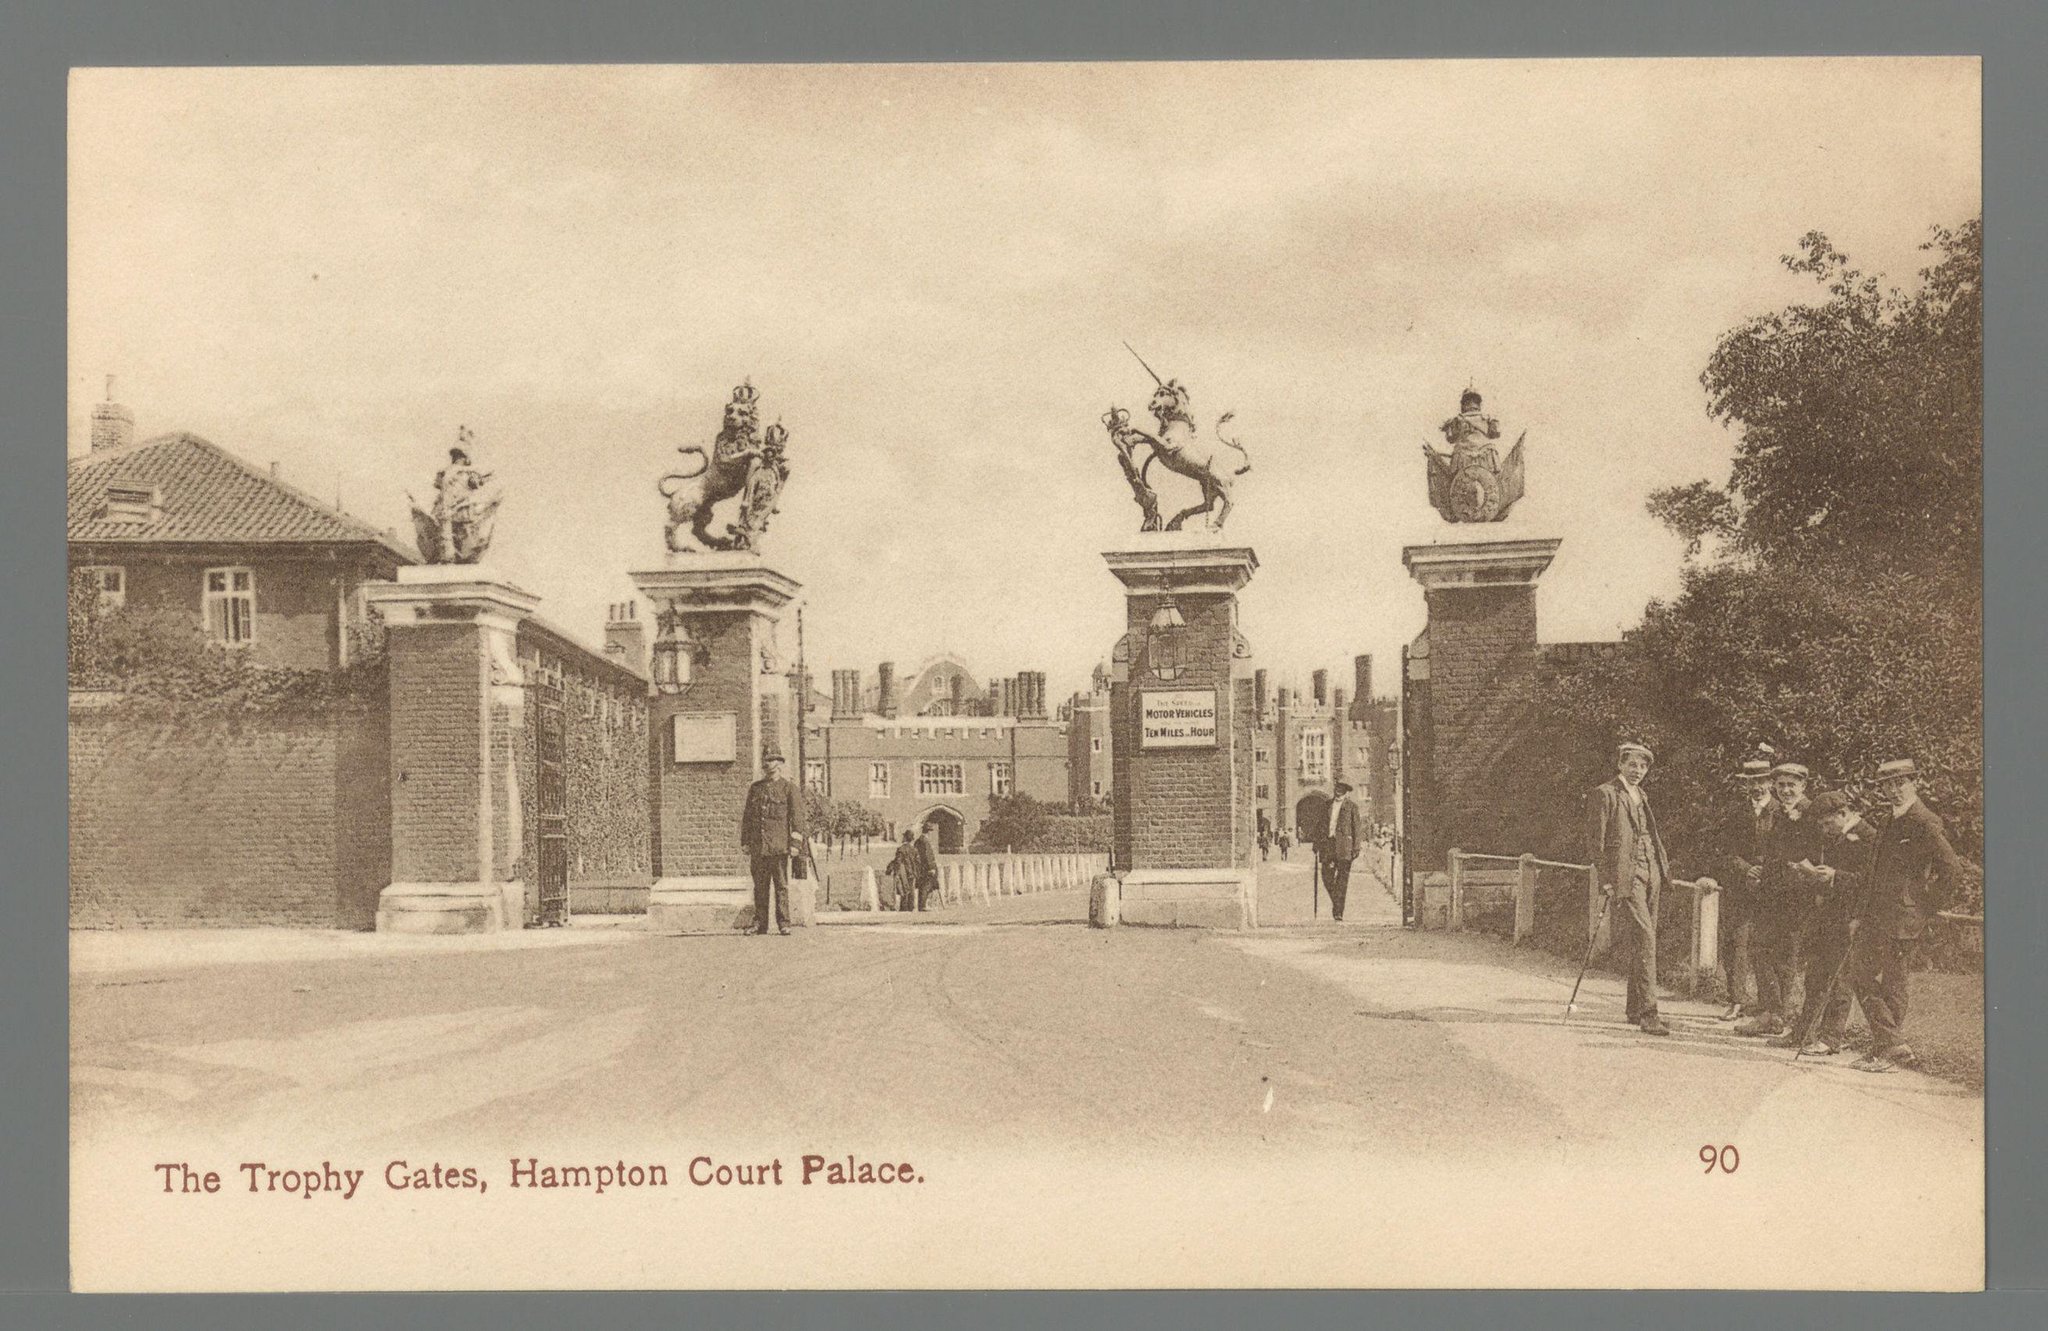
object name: ansichtkaart, prentbriefkaart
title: The Trophy Gates, Hampton Court Palace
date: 1902-1930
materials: cardboard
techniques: photograph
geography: england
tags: fence, wall, paling, palace, gate, entrance, monument, statue